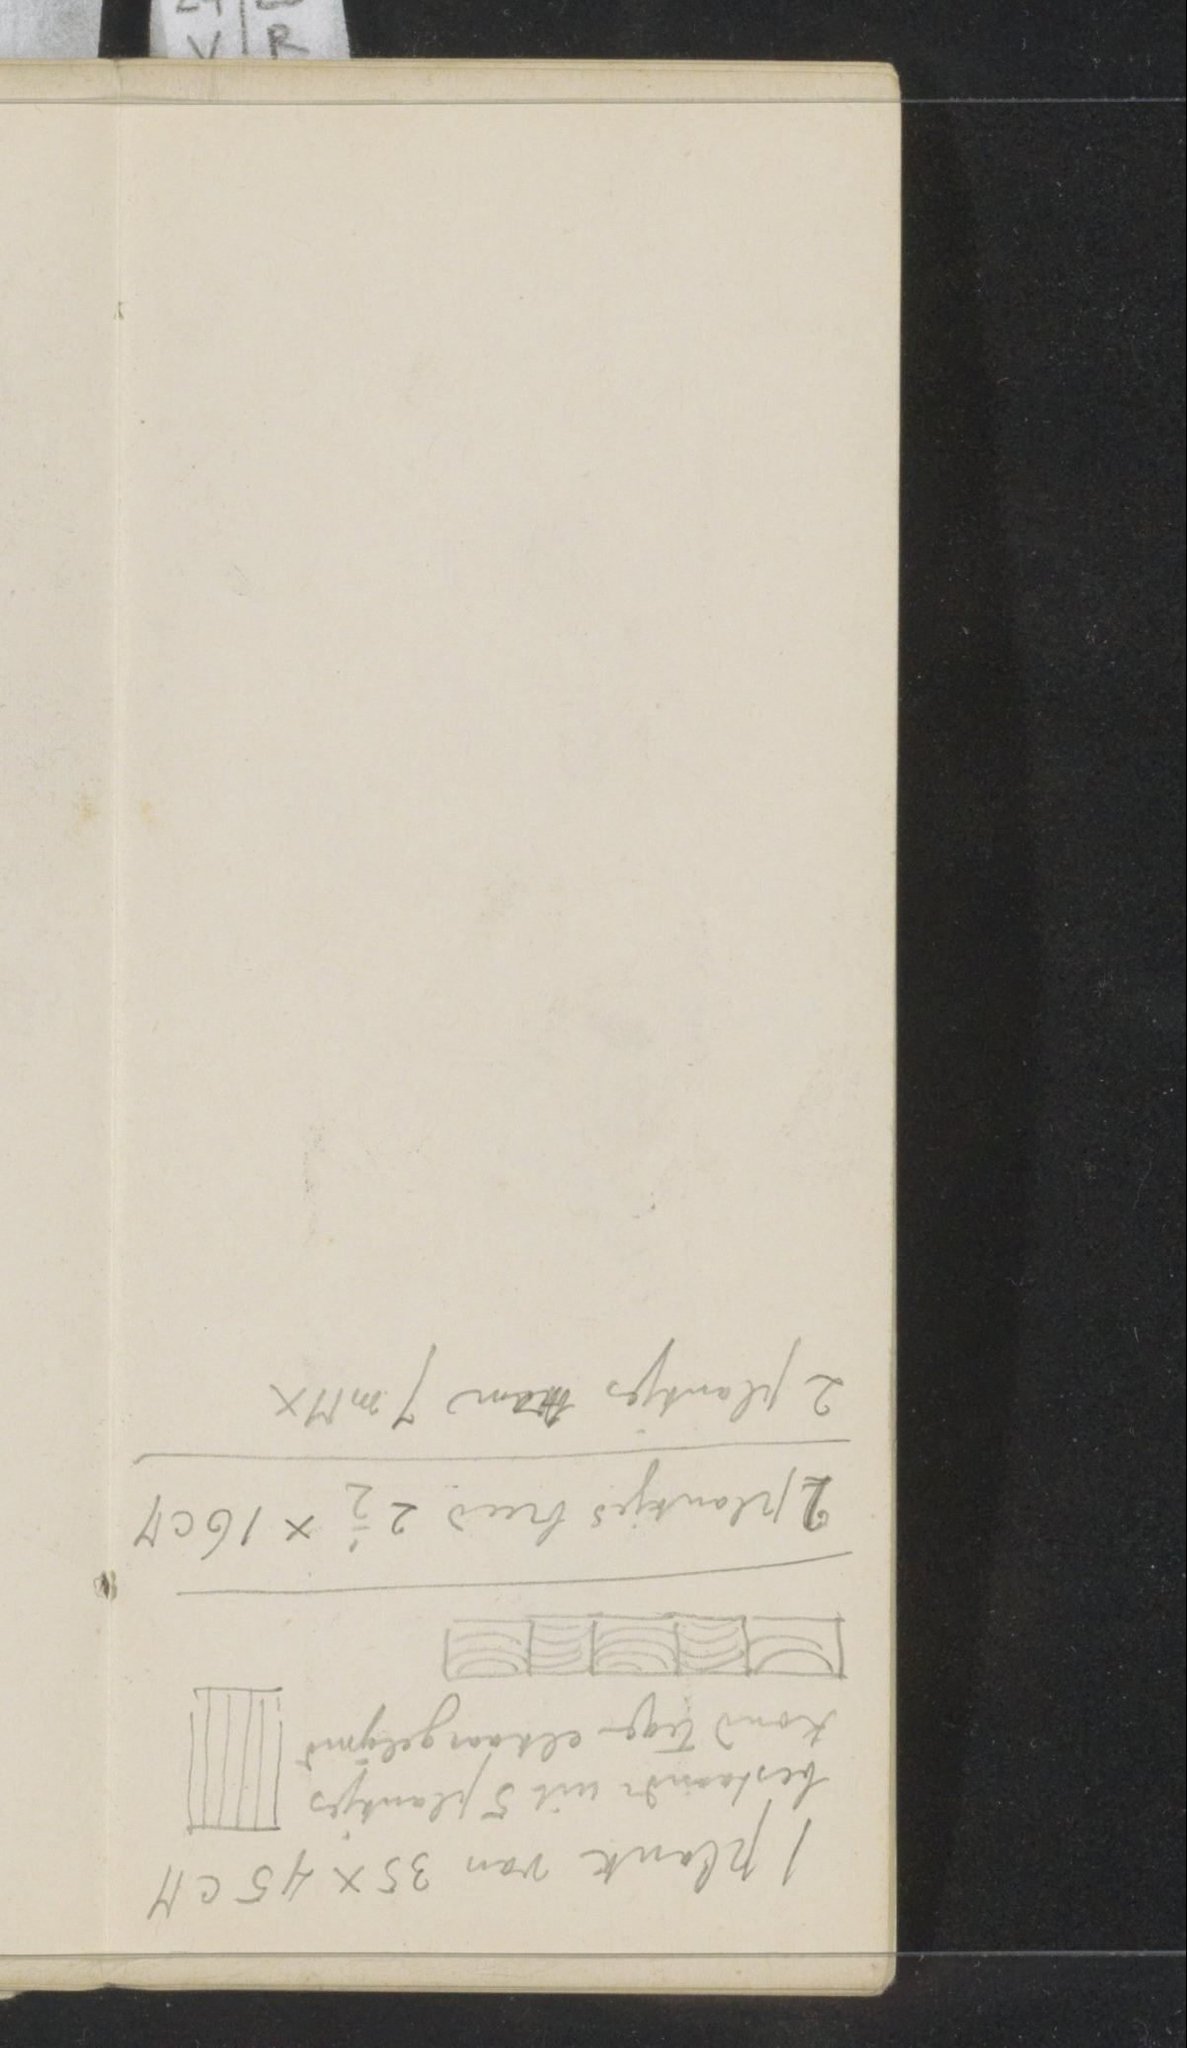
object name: sketchbook leaf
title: Planken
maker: gerrit willem dijsselhof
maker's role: designer, draughtsman, print maker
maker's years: 1866-1924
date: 1901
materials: paper, pencil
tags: plank, board ~ building material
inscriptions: annotation: ‘1 plank van 35 x 45 cm/ bestaande uit 5 plankjes/ koud tegen elkaar gelijmd/ [...]’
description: Blad 22 recto uit een schetsboek met 42 bladzijden.